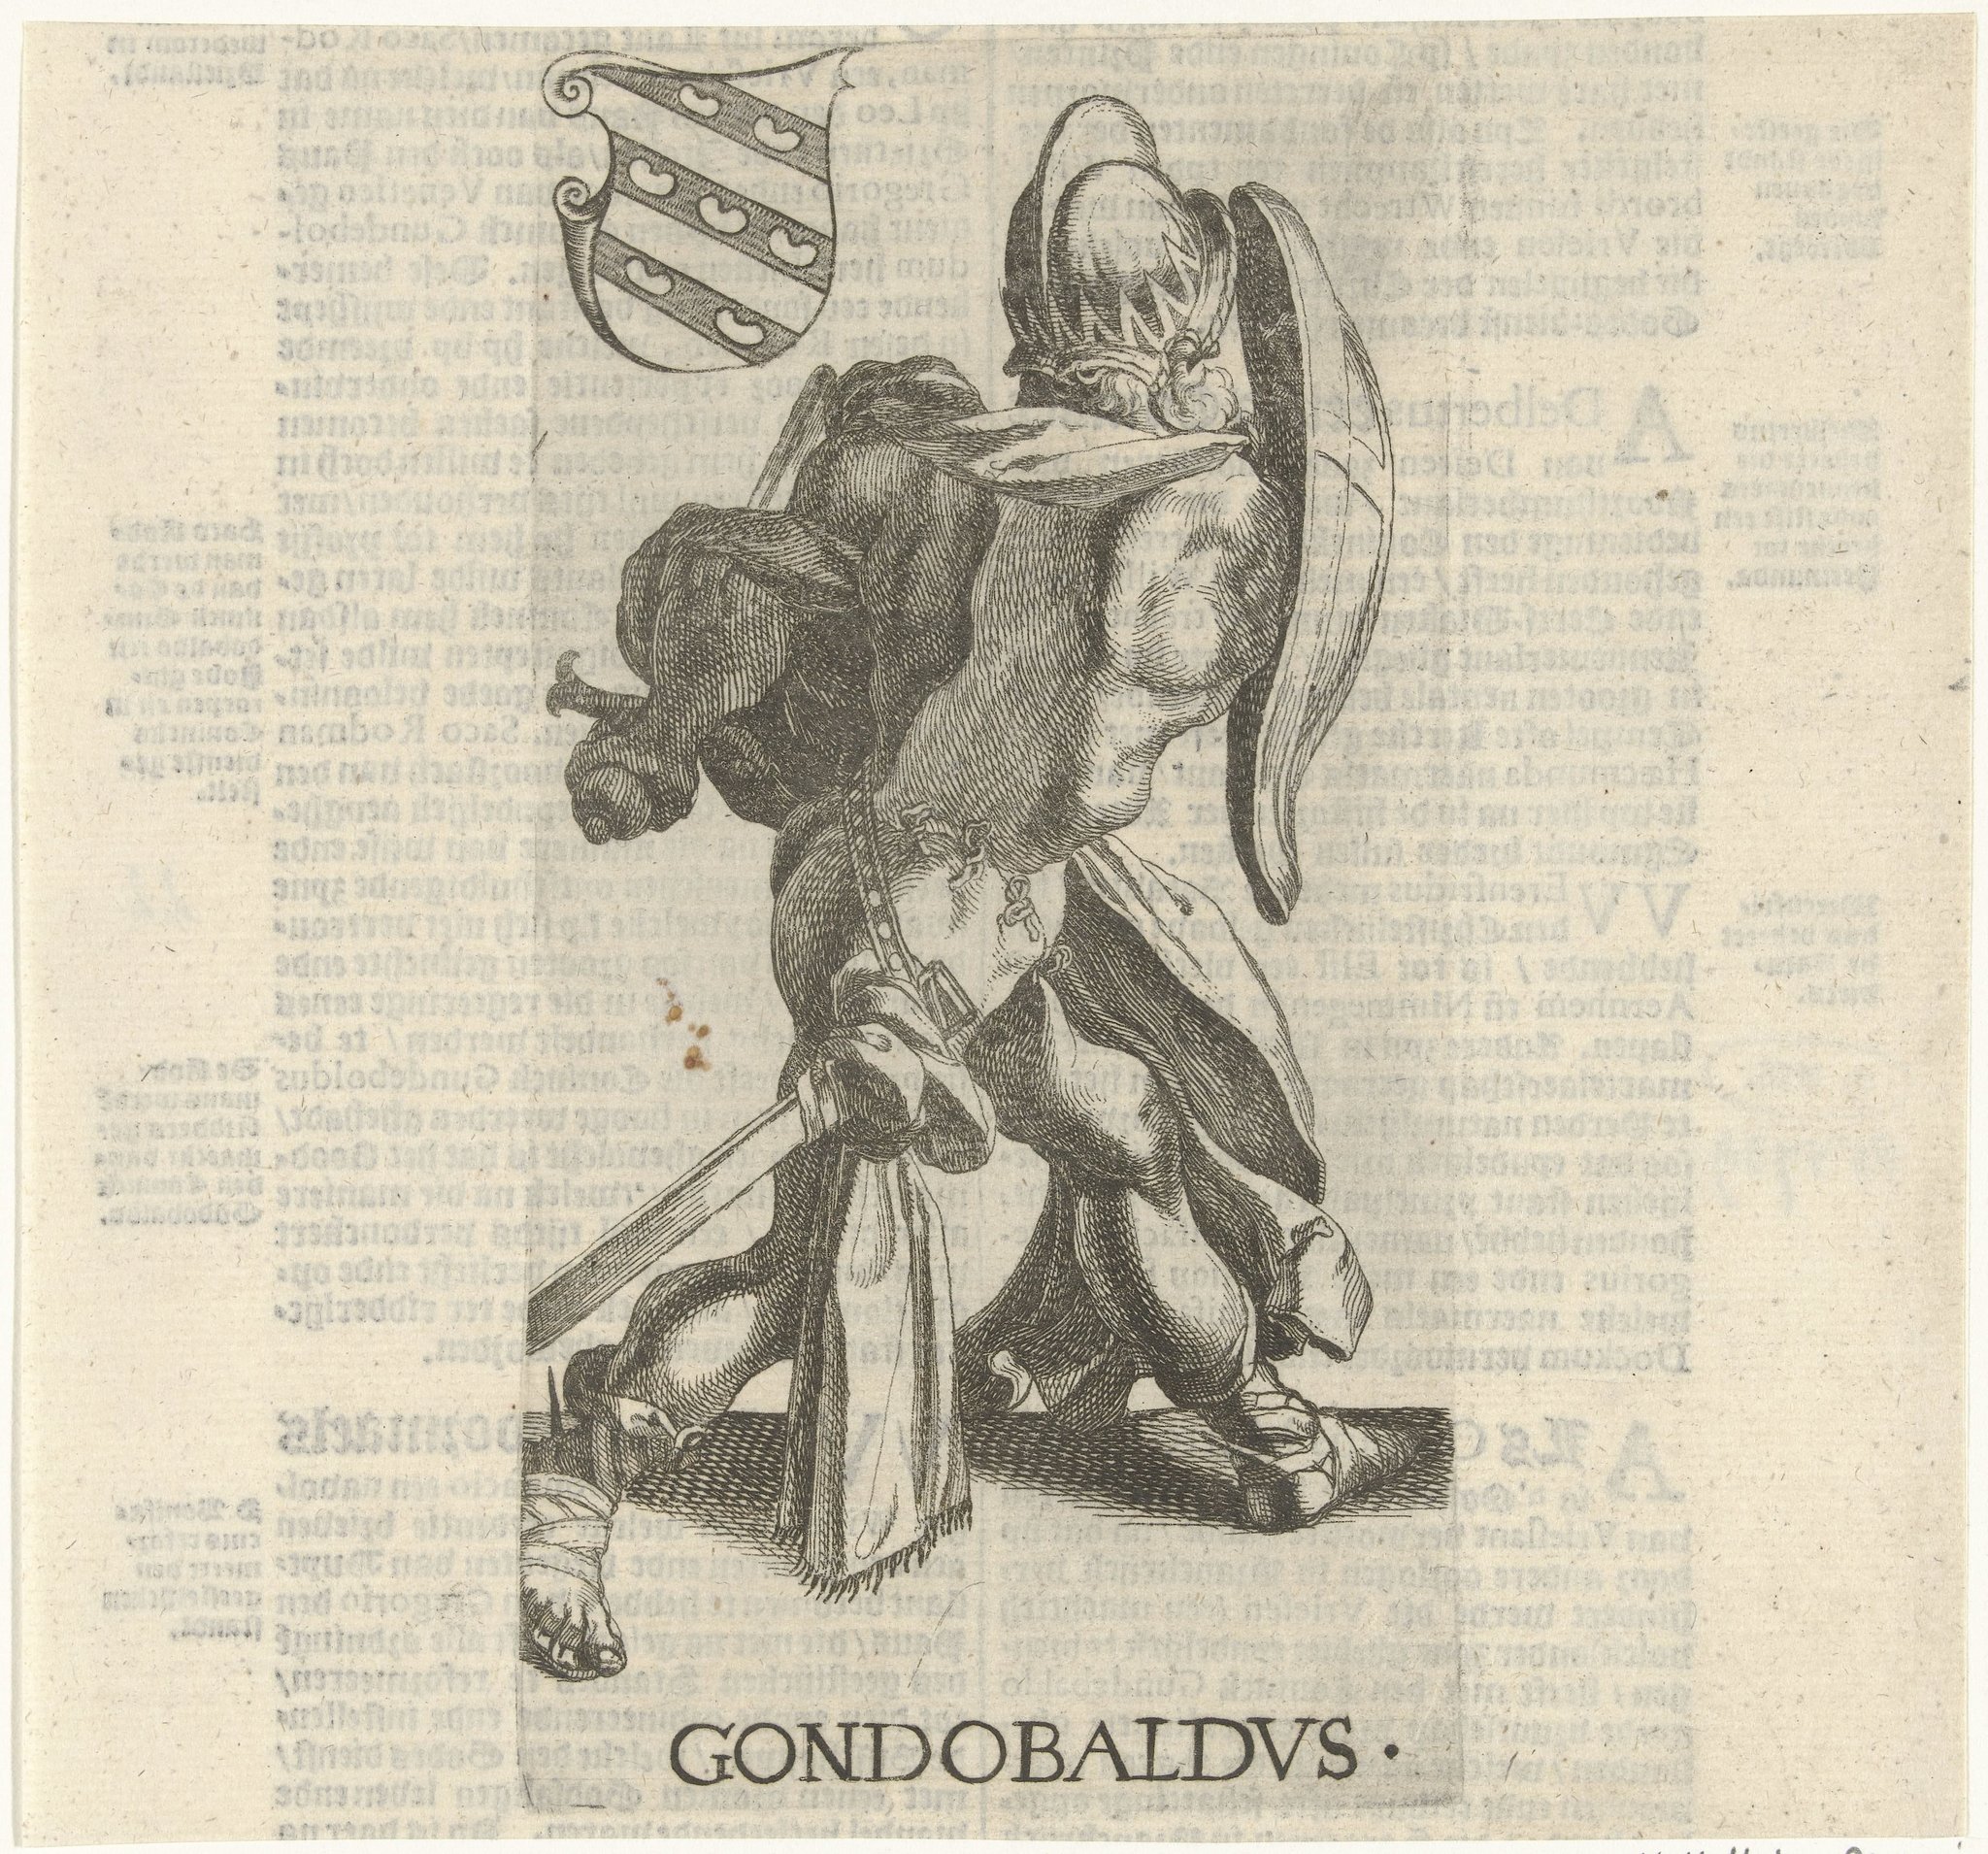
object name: print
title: Gondobaldus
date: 1622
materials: paper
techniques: etching, letterpress printing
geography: northern netherlands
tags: koning, gondobaldus (koning der friezen)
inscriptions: collector's mark: Lugt 2228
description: De prent is ook als boekillustratie gebruikt in: Winsemius, P.W. Chronique ofte Historische geschiedenisse van Vrieslant (...). Franeker: Joannes Lamrinck, 1622.